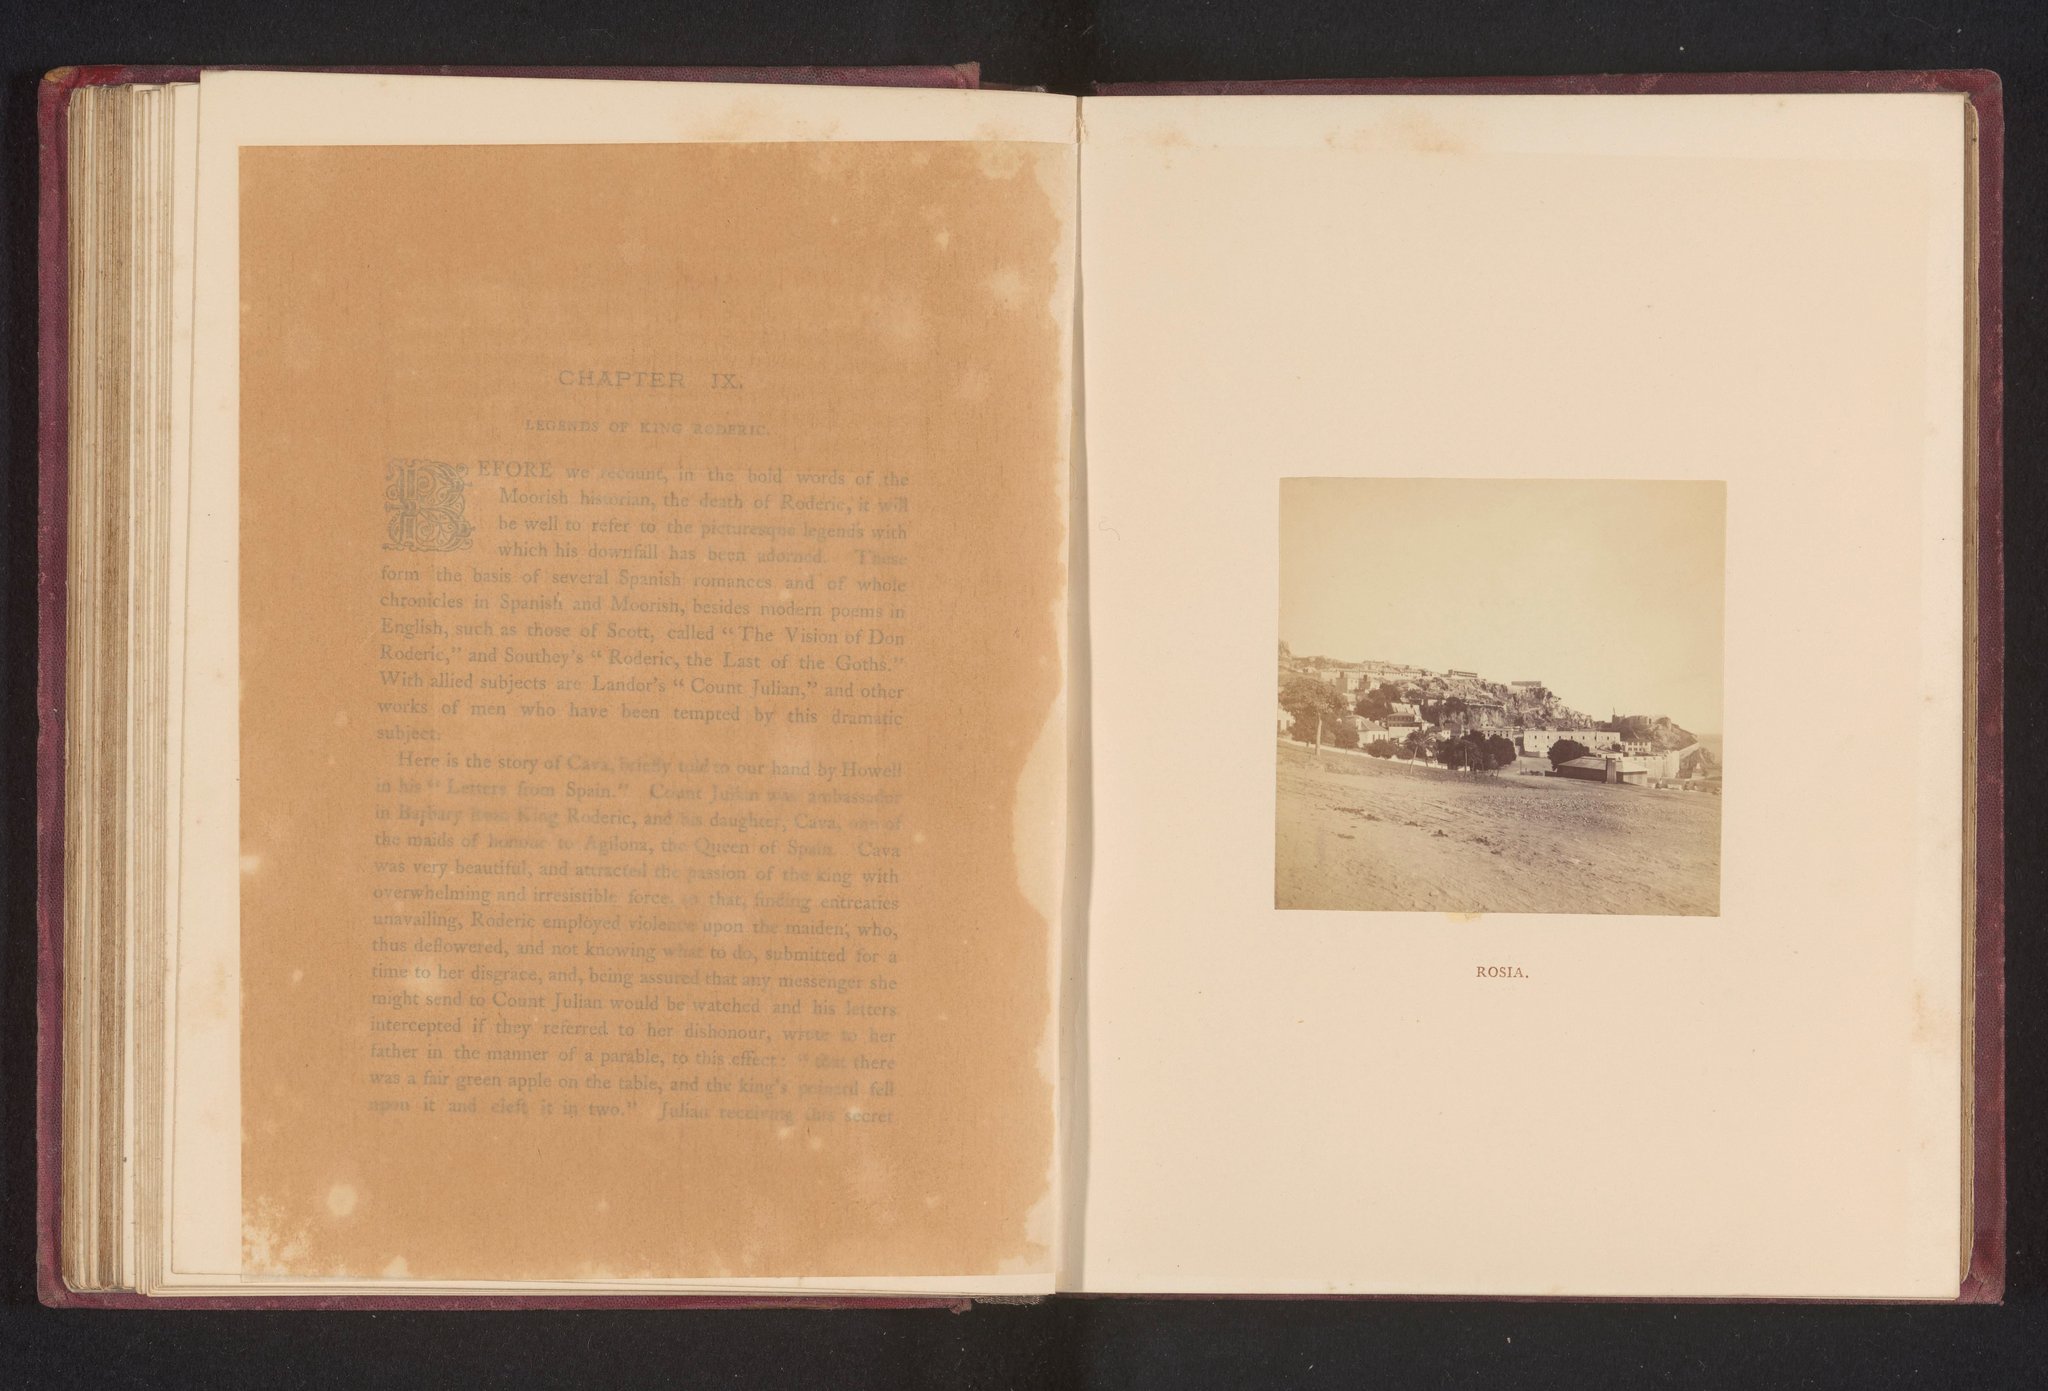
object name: photograph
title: Rosia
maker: j.h. mann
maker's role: fotograaf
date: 1860-1870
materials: photographic support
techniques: albumen print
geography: gibraltar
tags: gulf, bay, housing